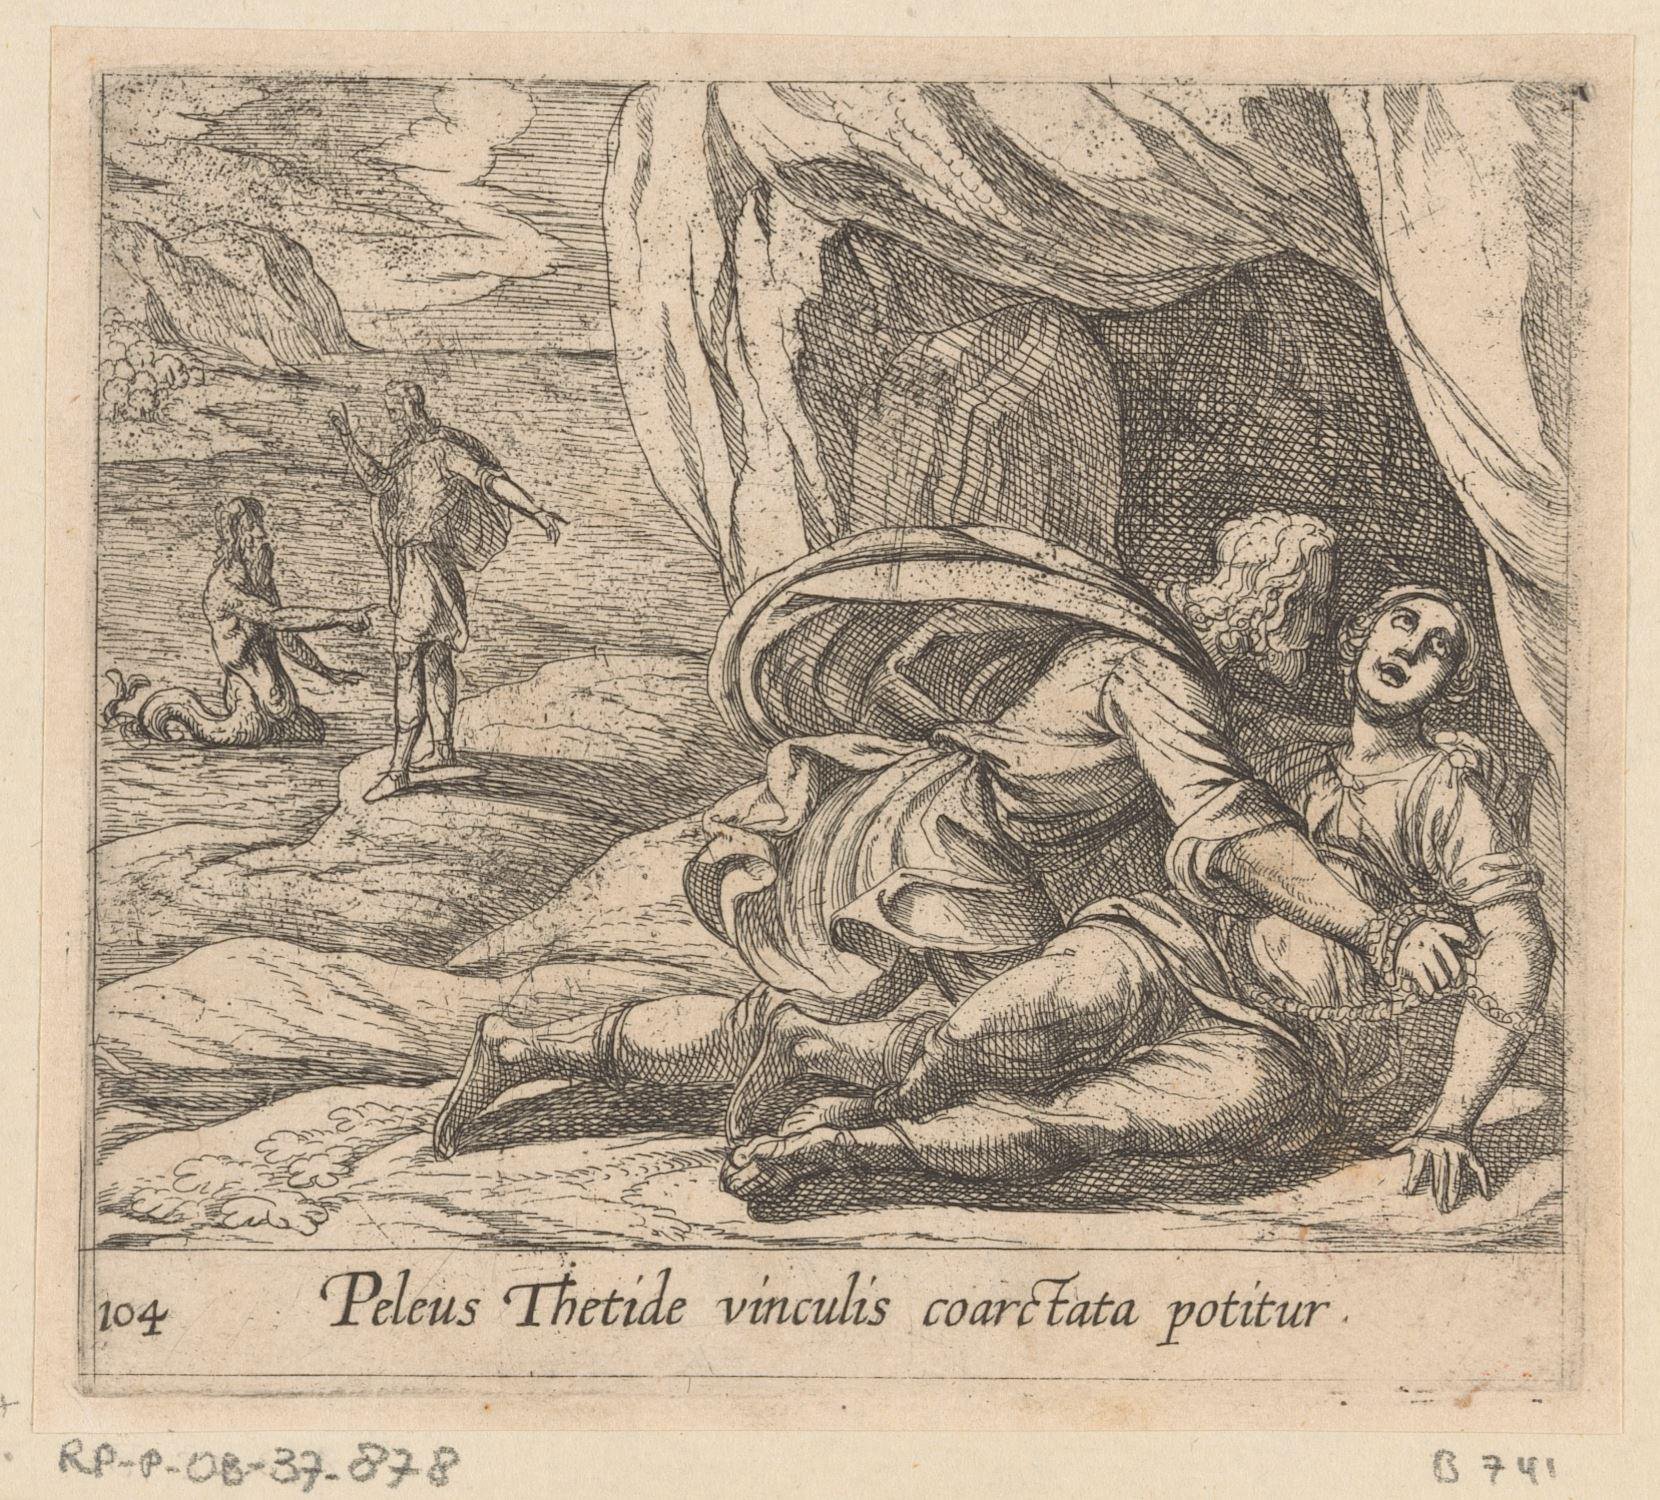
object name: print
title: Metamorphoseon sive transformationum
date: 1606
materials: paper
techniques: etching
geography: antwerp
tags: (story of) peleus and thetis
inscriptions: collector's mark: Lugt 240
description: Deze prent maakt deel uit van een reeks van 150 prenten (+ titelprent) met voorstellingen van de Metamorfosen van Ovidius.